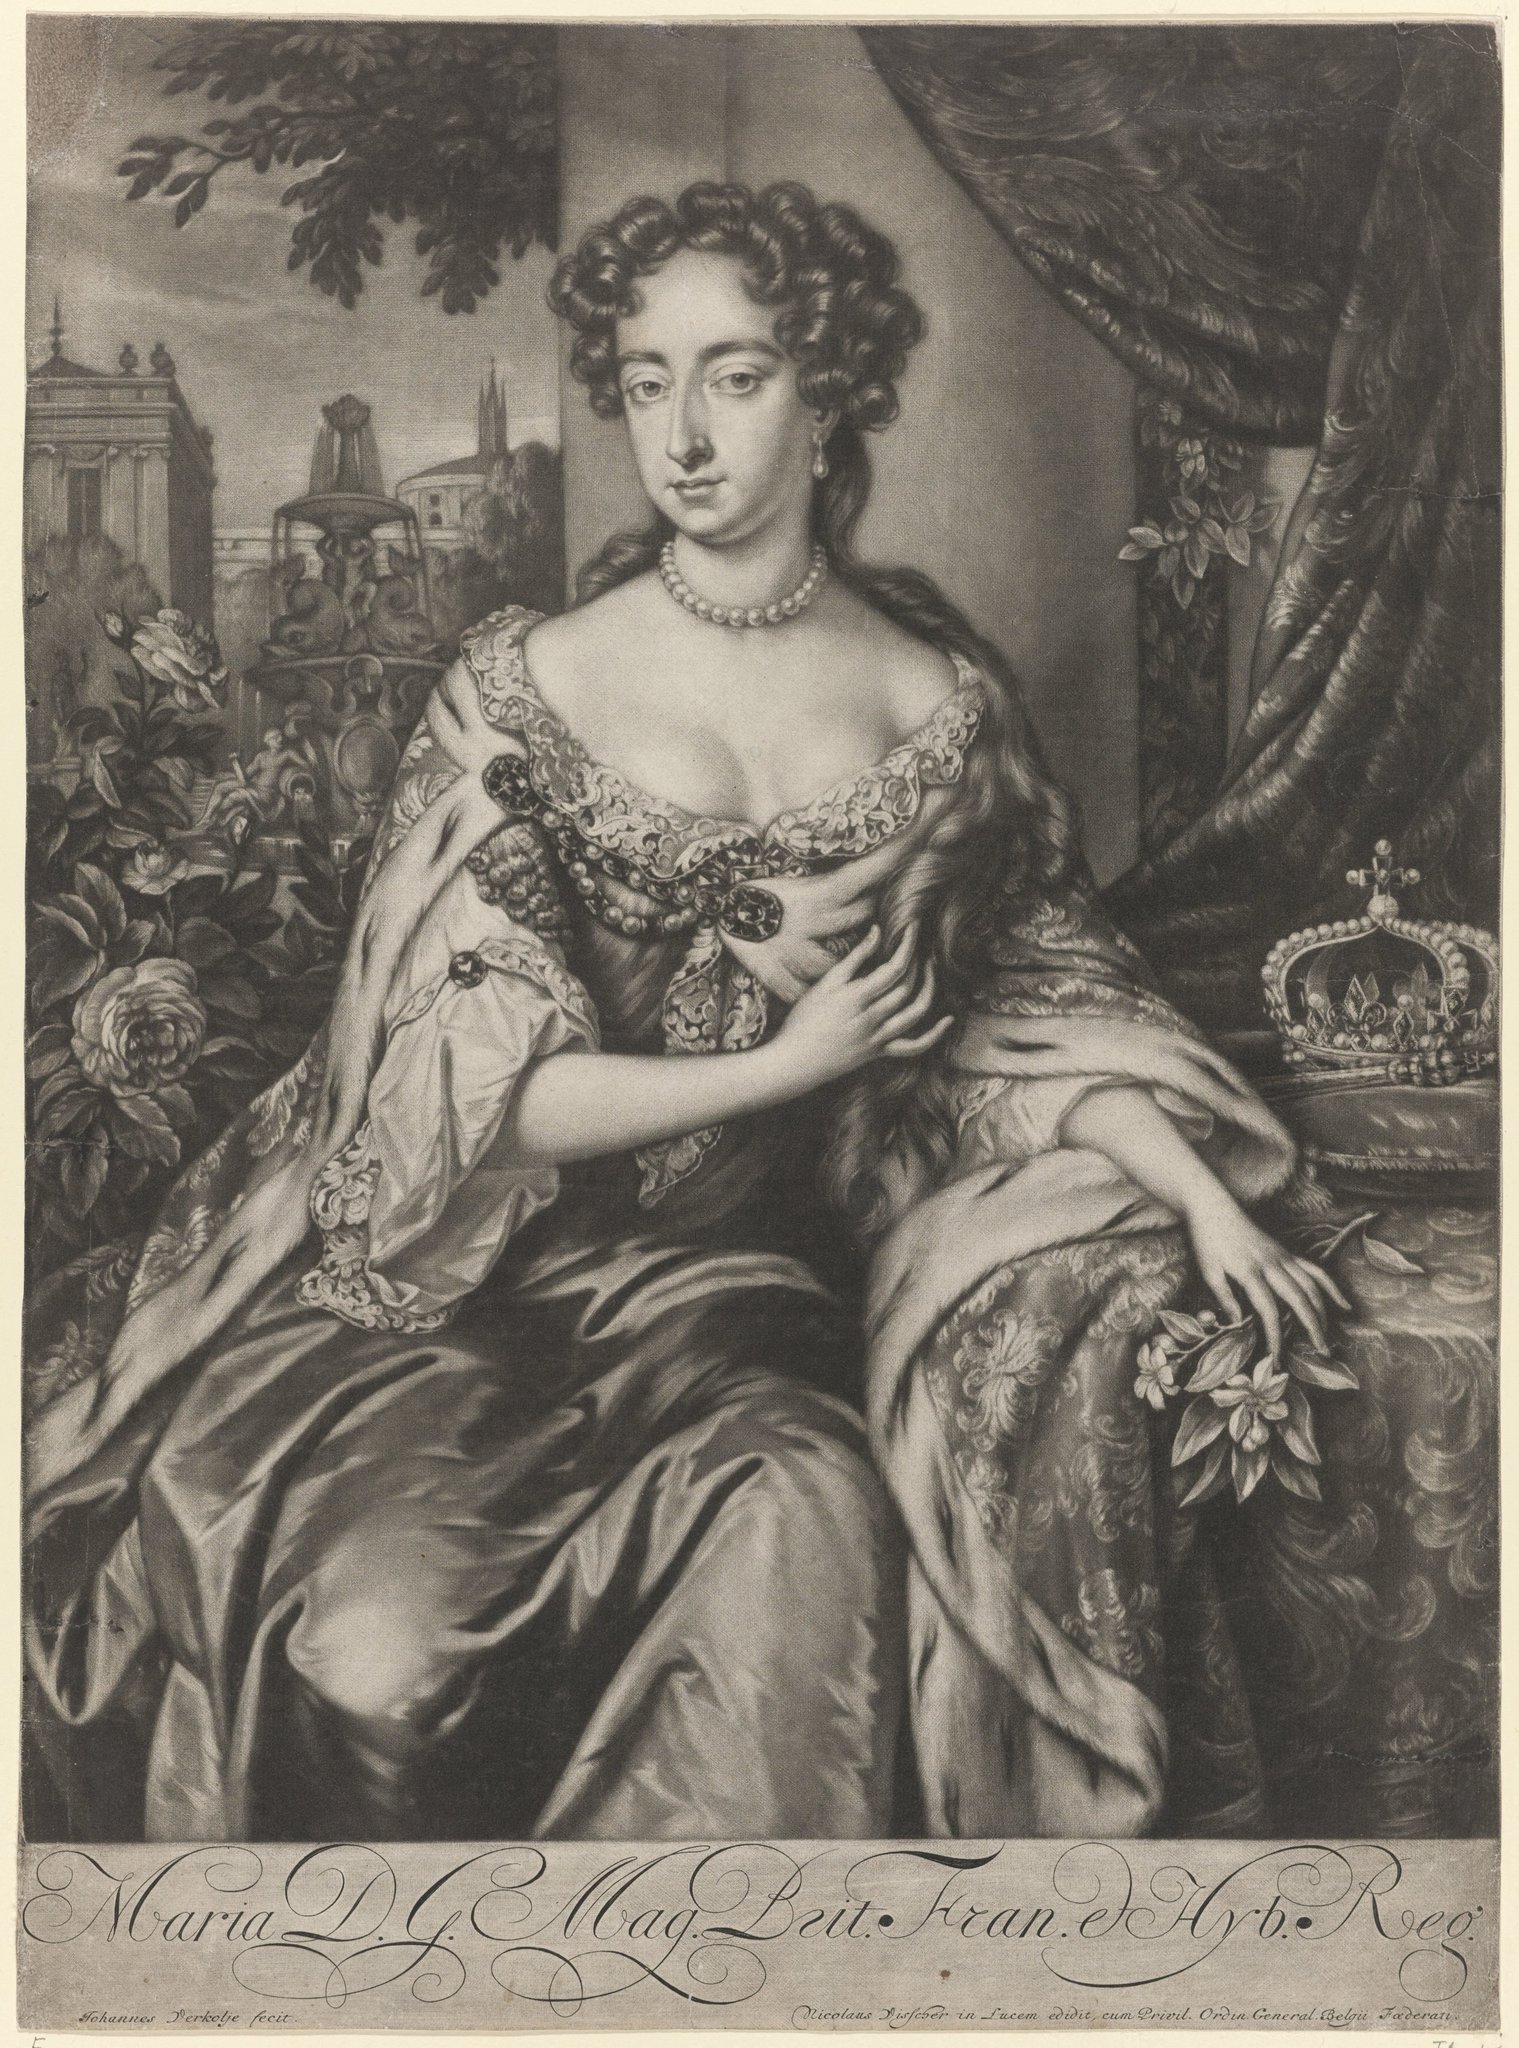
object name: print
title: Portret van Maria II Stuart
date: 1688-1709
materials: paper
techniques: mezzotint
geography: delft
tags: london, maria ii stuart (koningin van engeland, schotland en ierland)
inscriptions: collector's mark: Lugt 963, collector's mark: Lugt 2165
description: Portret van Maria II. Ze zit naast een tafel met daarop een kroon en een scepter. In de ondermarge haar naam en titels.